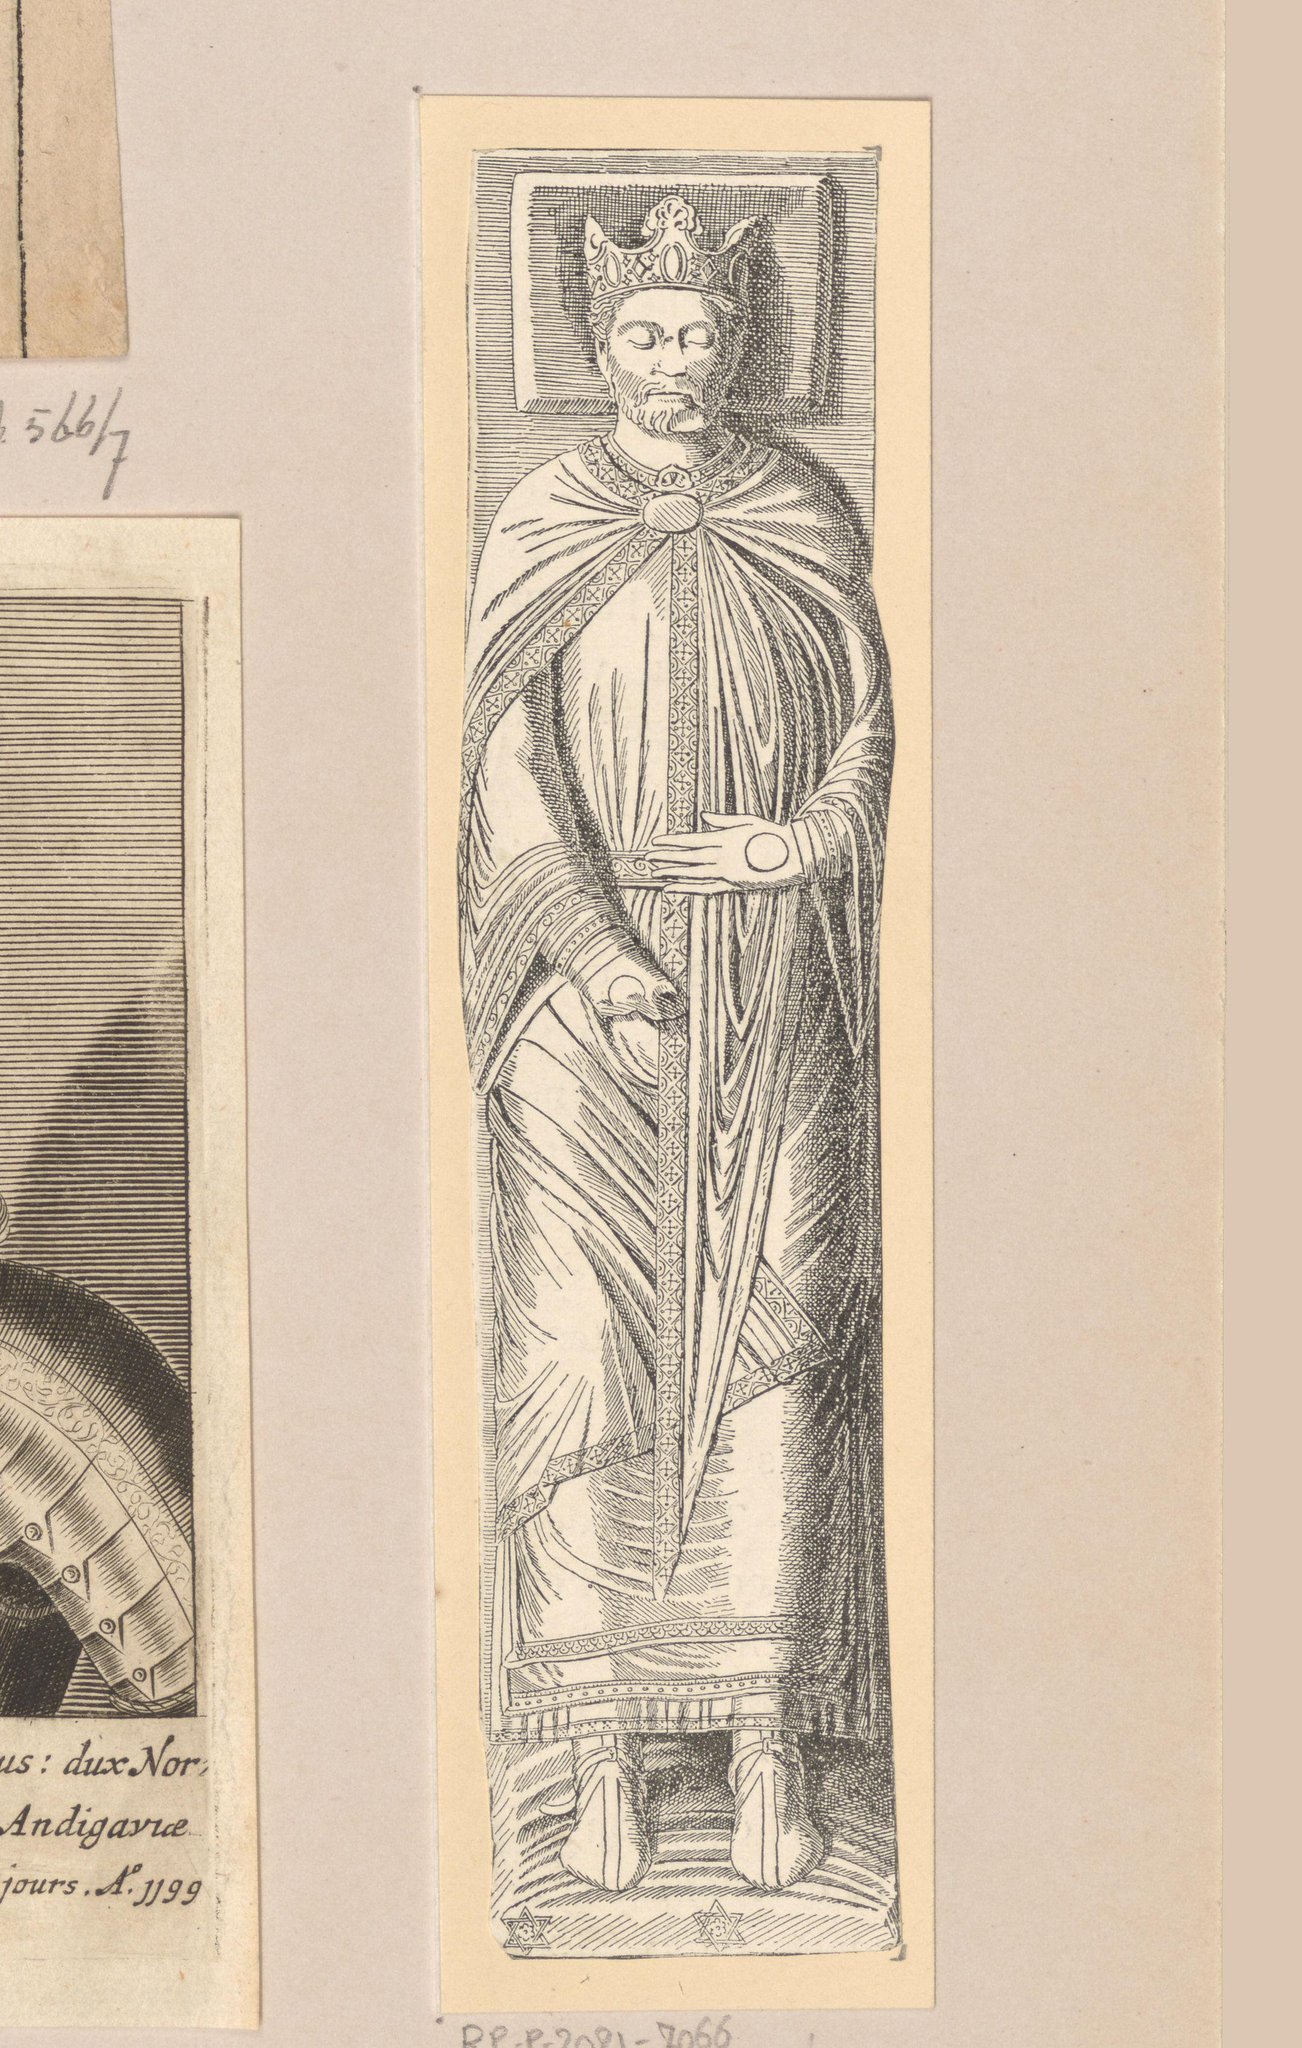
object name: photomechanical print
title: Grafmonument van Richard I Leeuwenhart, koning van Engeland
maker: Anonymous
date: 1800-1899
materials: paper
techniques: line block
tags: historical persons, grave, tomb, king